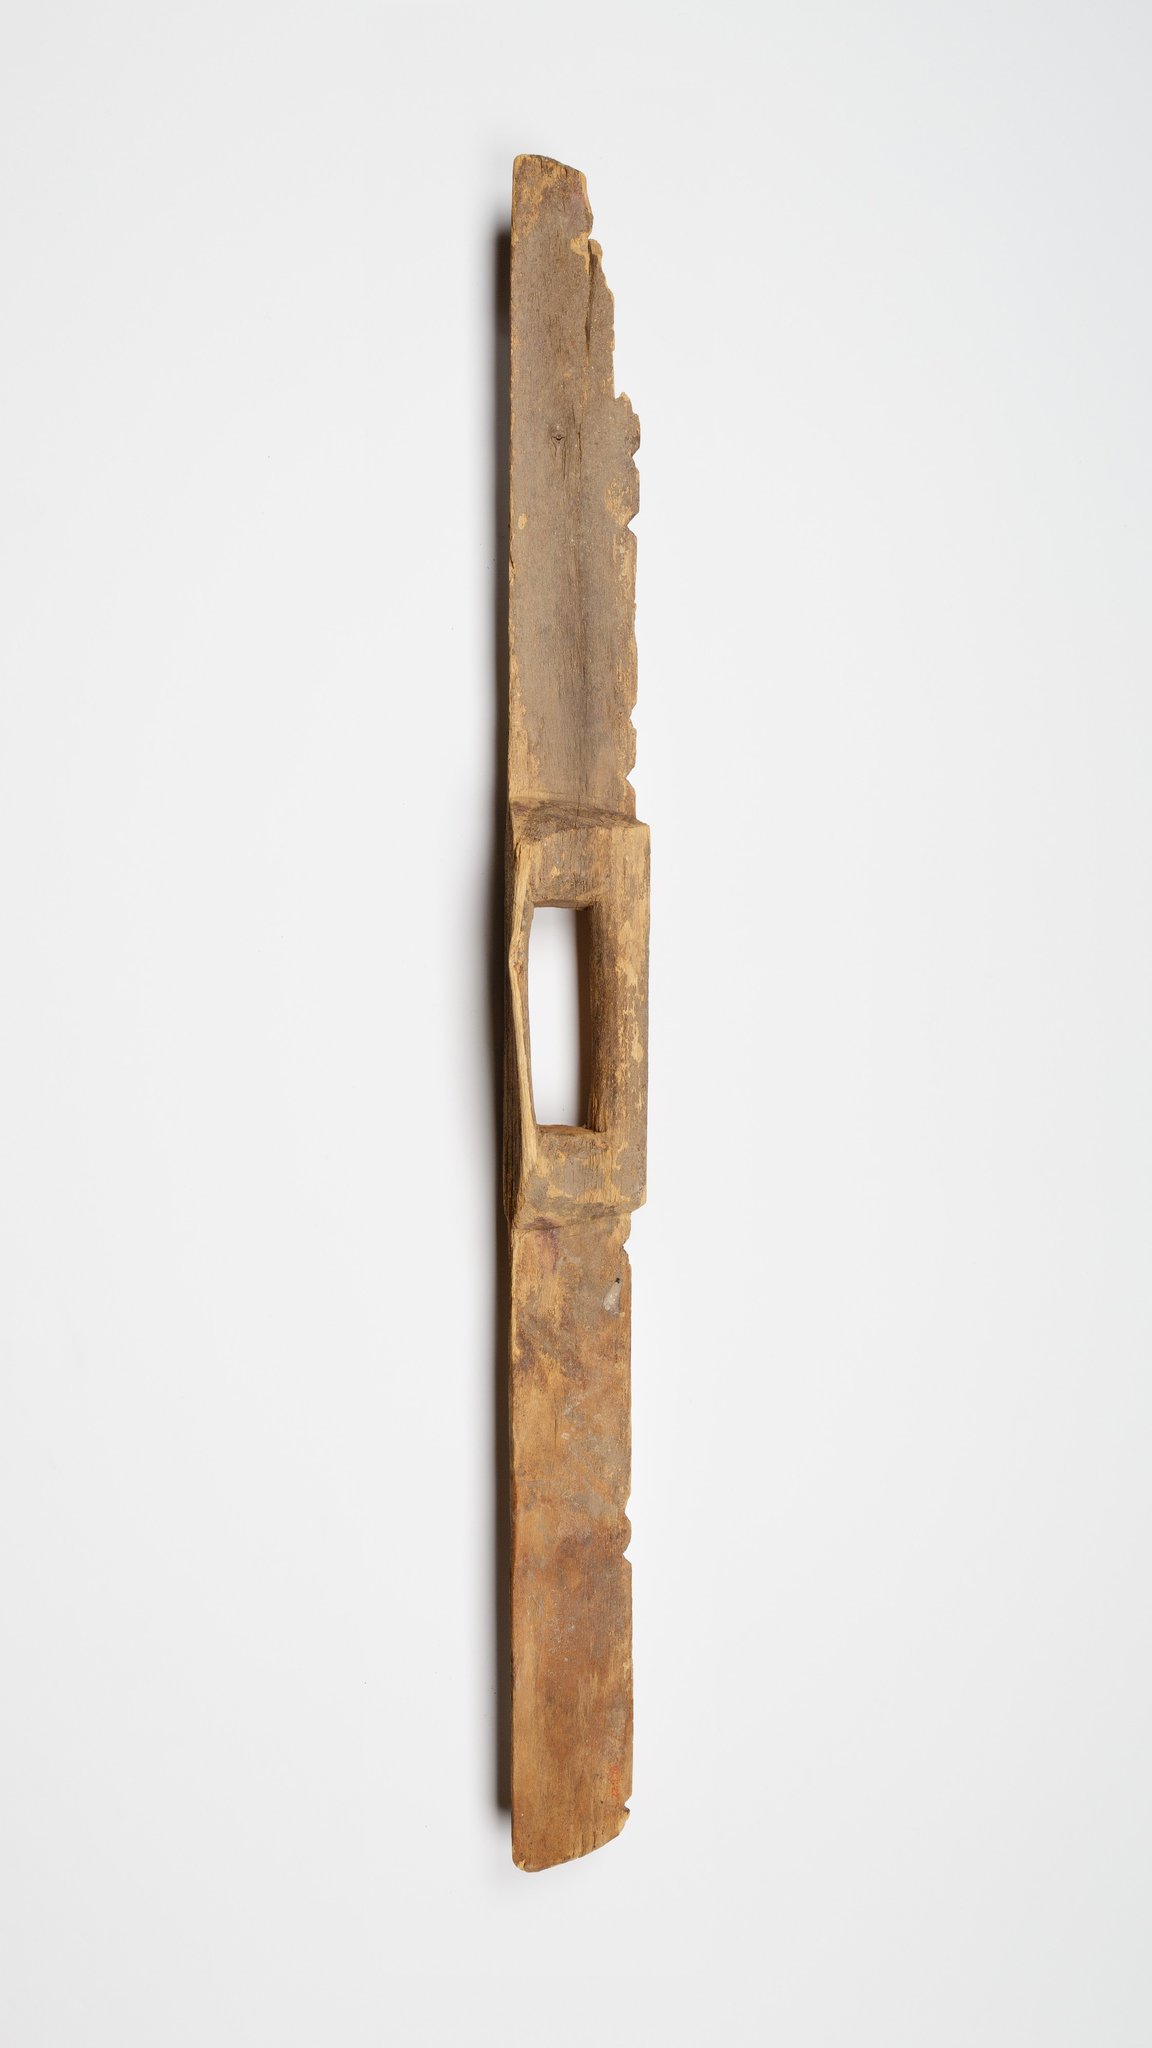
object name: shield handle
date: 2124-1504 BCE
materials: wood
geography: egypt